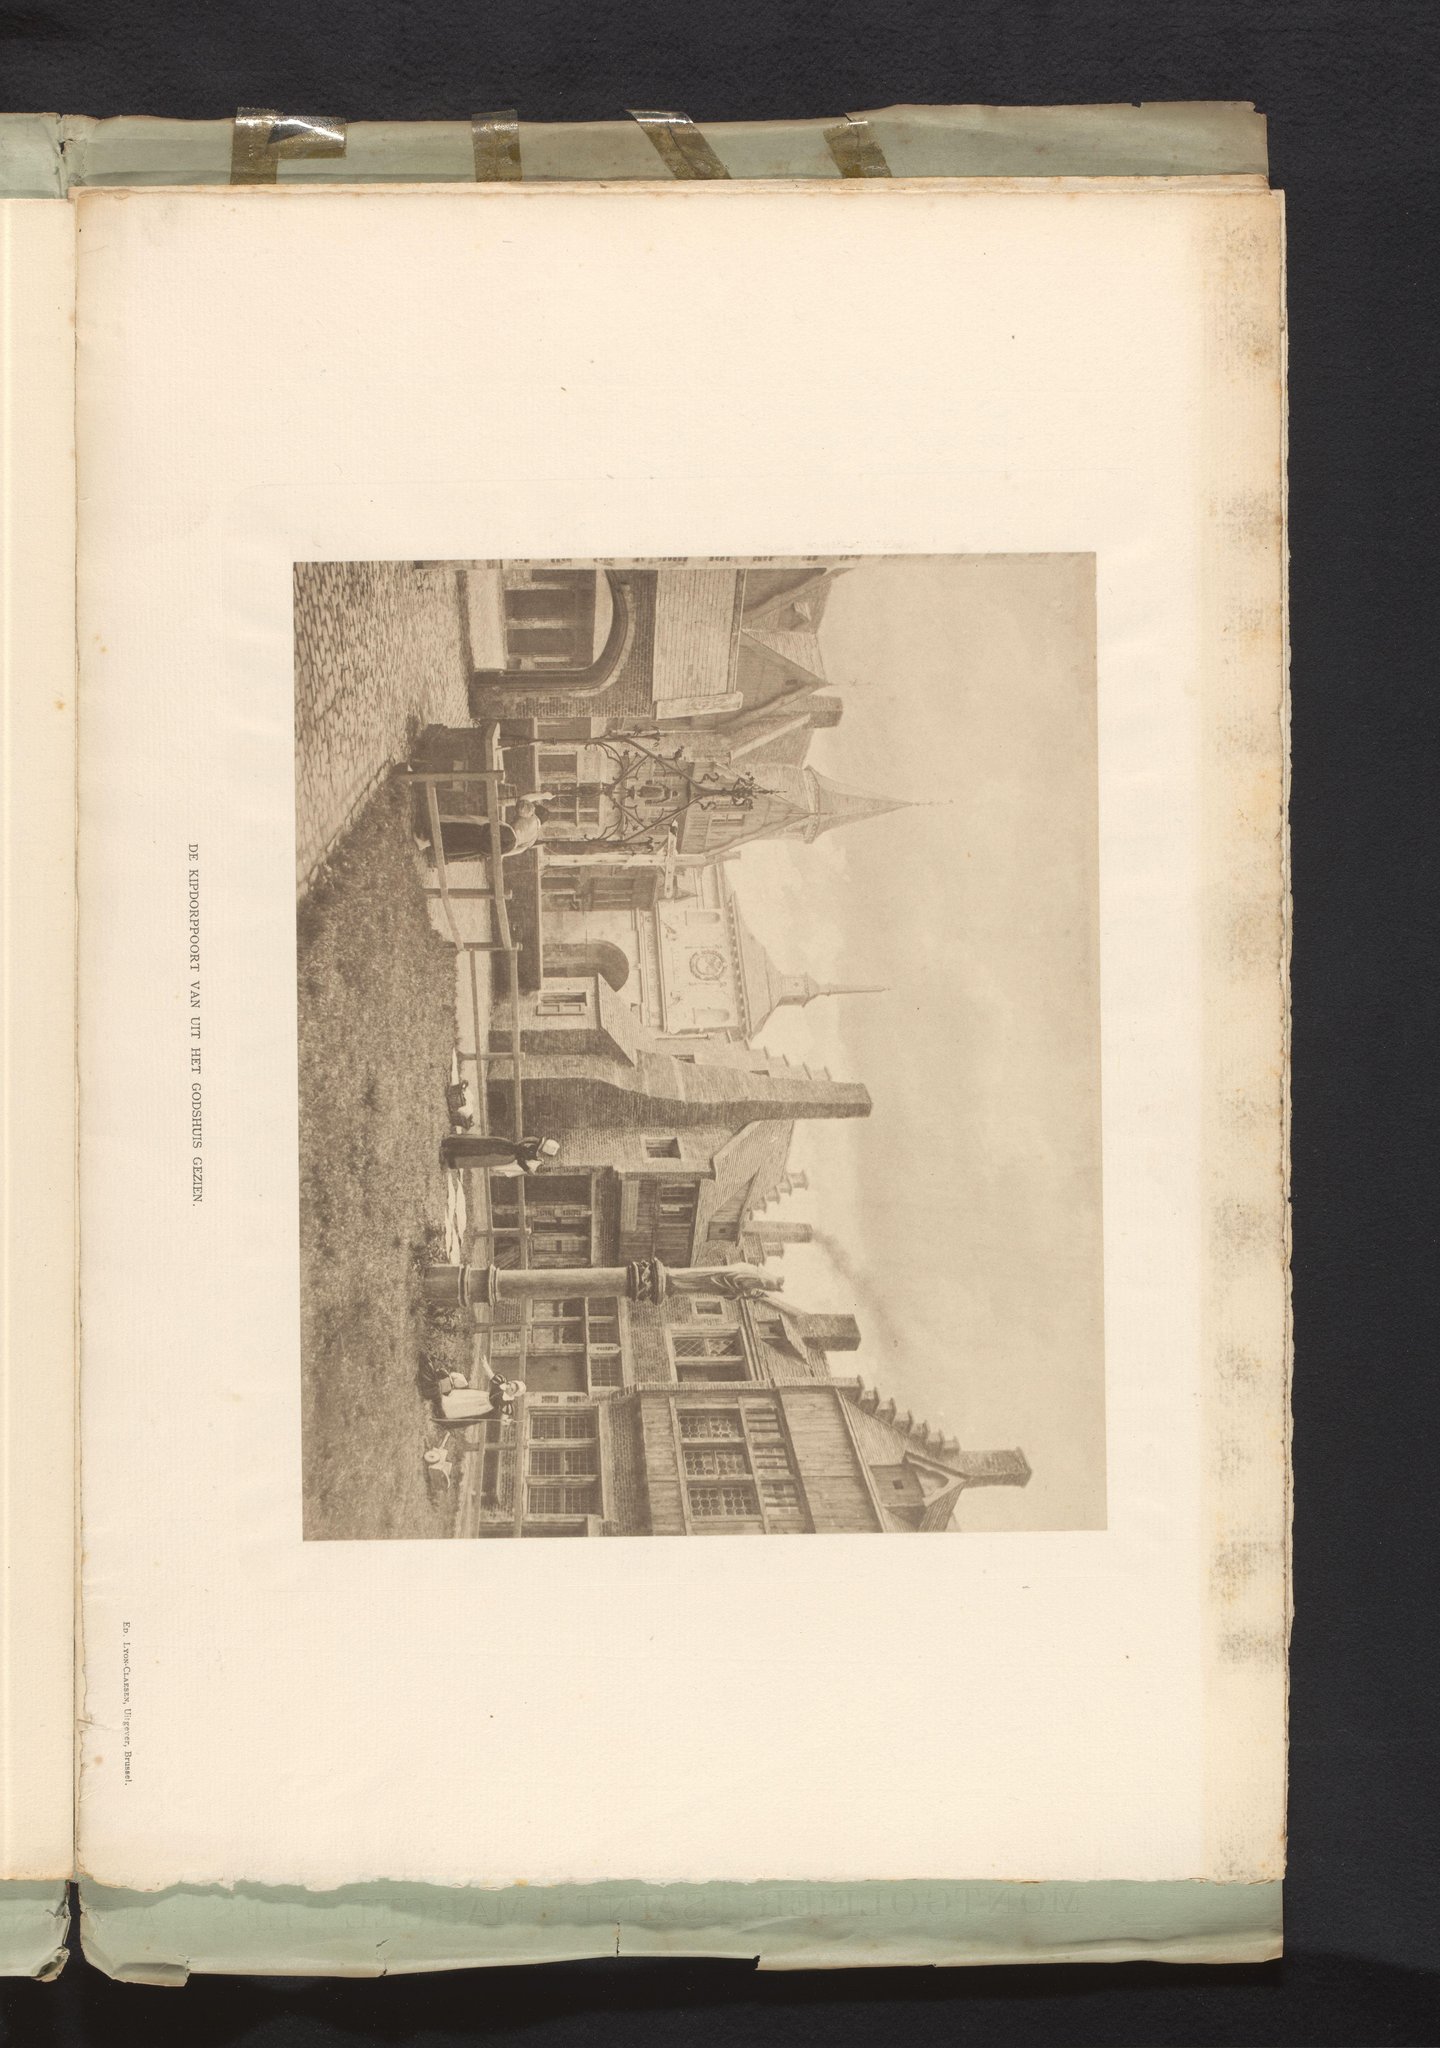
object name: photomechanical print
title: Gezicht op de Kipdorppoort in Oud-Antwerpen op de Wereldtentoonstelling van 1894 in Antwerpen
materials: paper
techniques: photograph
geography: antwerp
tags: world fair, world exhibition, city-gate, antwerp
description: Prent op los blad tussen pagina 20 en 21.